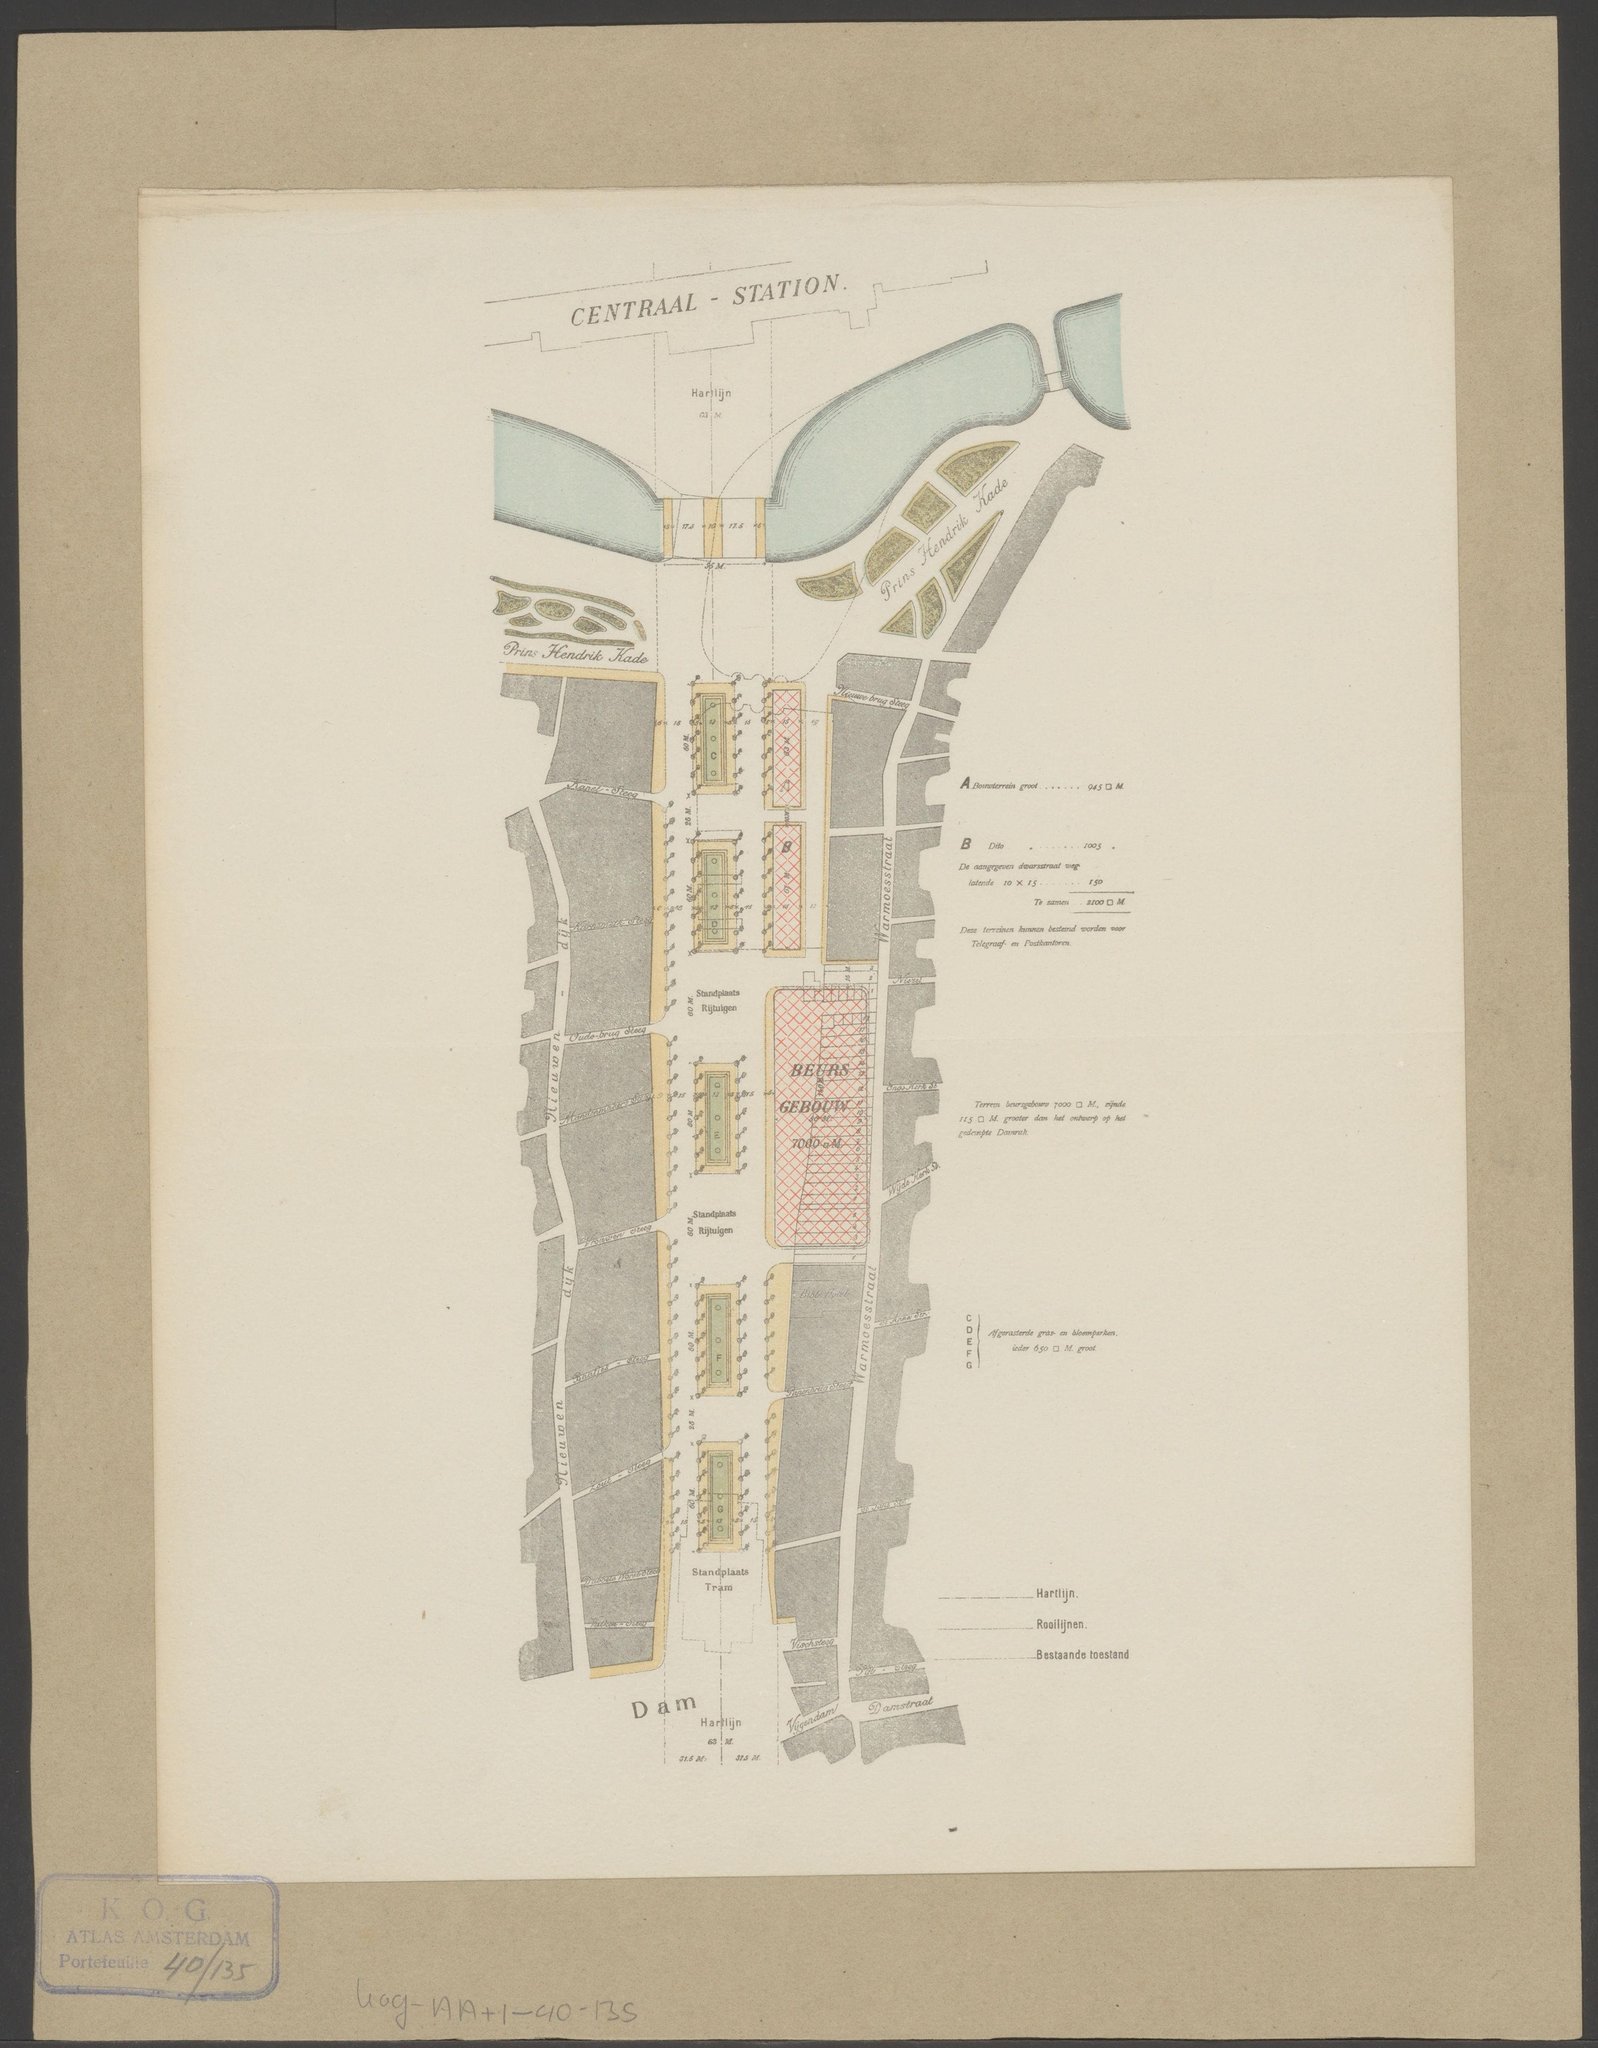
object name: print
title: Gezicht op een mogelijk beursgebouw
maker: Anonymous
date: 1884-1898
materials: paper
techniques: lithograph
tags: design, plan (~ production), stock exchange, stock-market, amsterdam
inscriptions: collector's mark: Lugt 1641b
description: Onderwerpsrubriek binnen de Atlas Amsterdam: Handel en Zeevaart, D. Beurs-Ontwerpen.